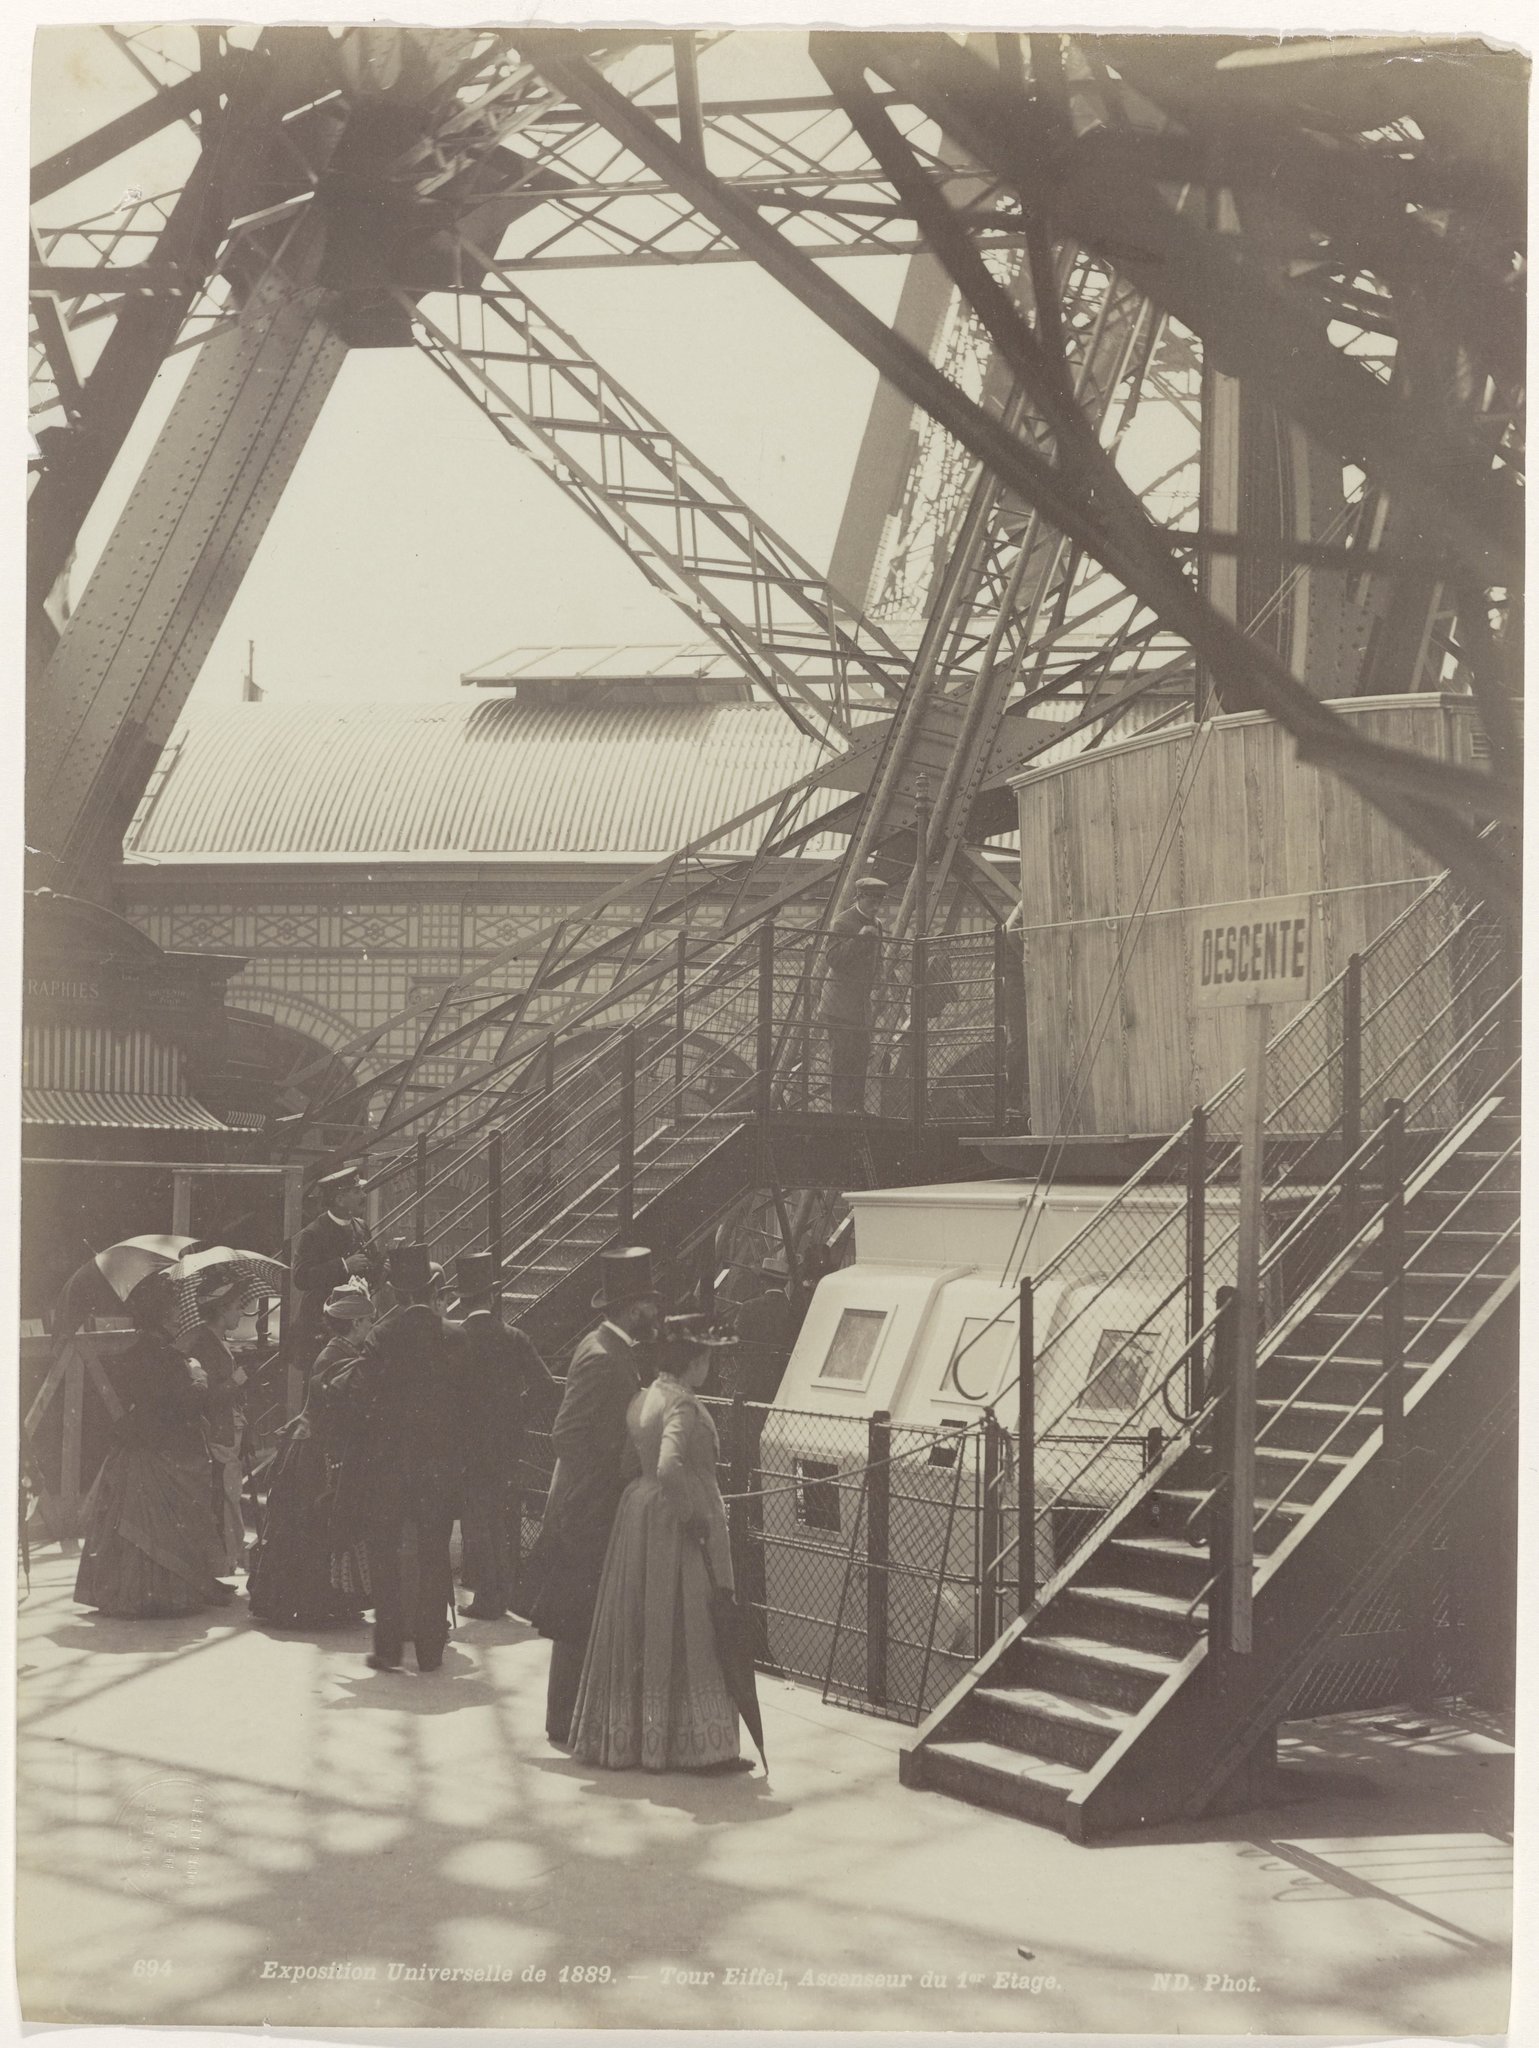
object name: photograph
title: Exposition Universelle de 1889 - Tour Eiffel, ascenseur du 1er etage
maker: jules hautecoeur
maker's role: publisher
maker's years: 1849-1935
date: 1889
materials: paper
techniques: albumen print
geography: paris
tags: world fair, world exhibition, eiffel tower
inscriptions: number: ‘694’, inscription: ‘SOCIÉTÉ/ DE LA/ TOUR EIFFEL’